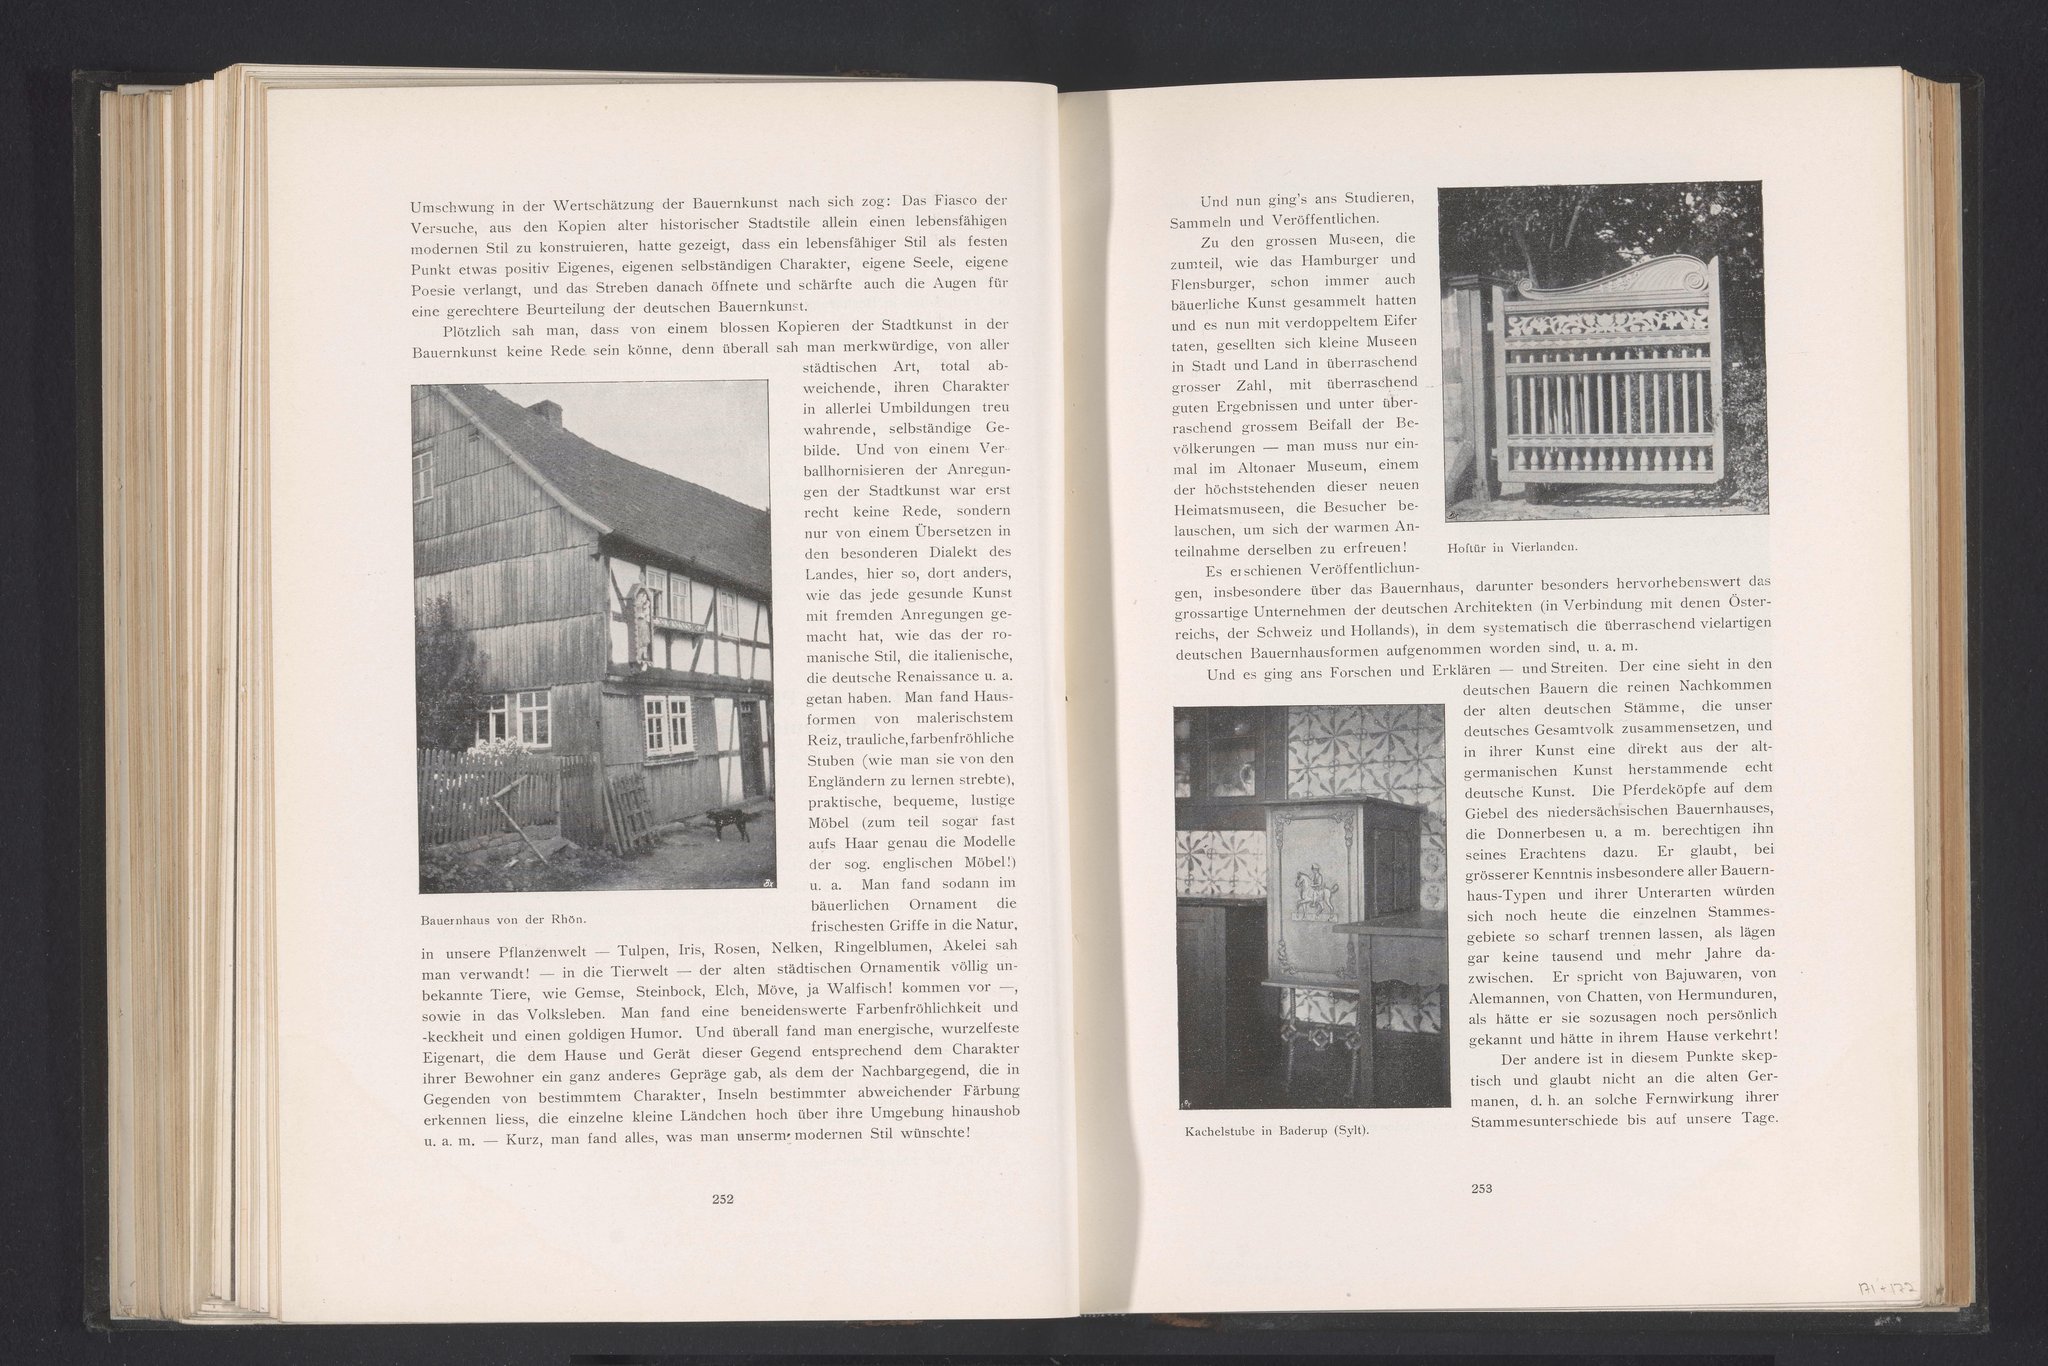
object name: photomechanical print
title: Hoek van een boerderij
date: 1898-1903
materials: paper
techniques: autotype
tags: façade (of house or building), farm or solitary house in landscape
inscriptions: monogram: ‘BX’